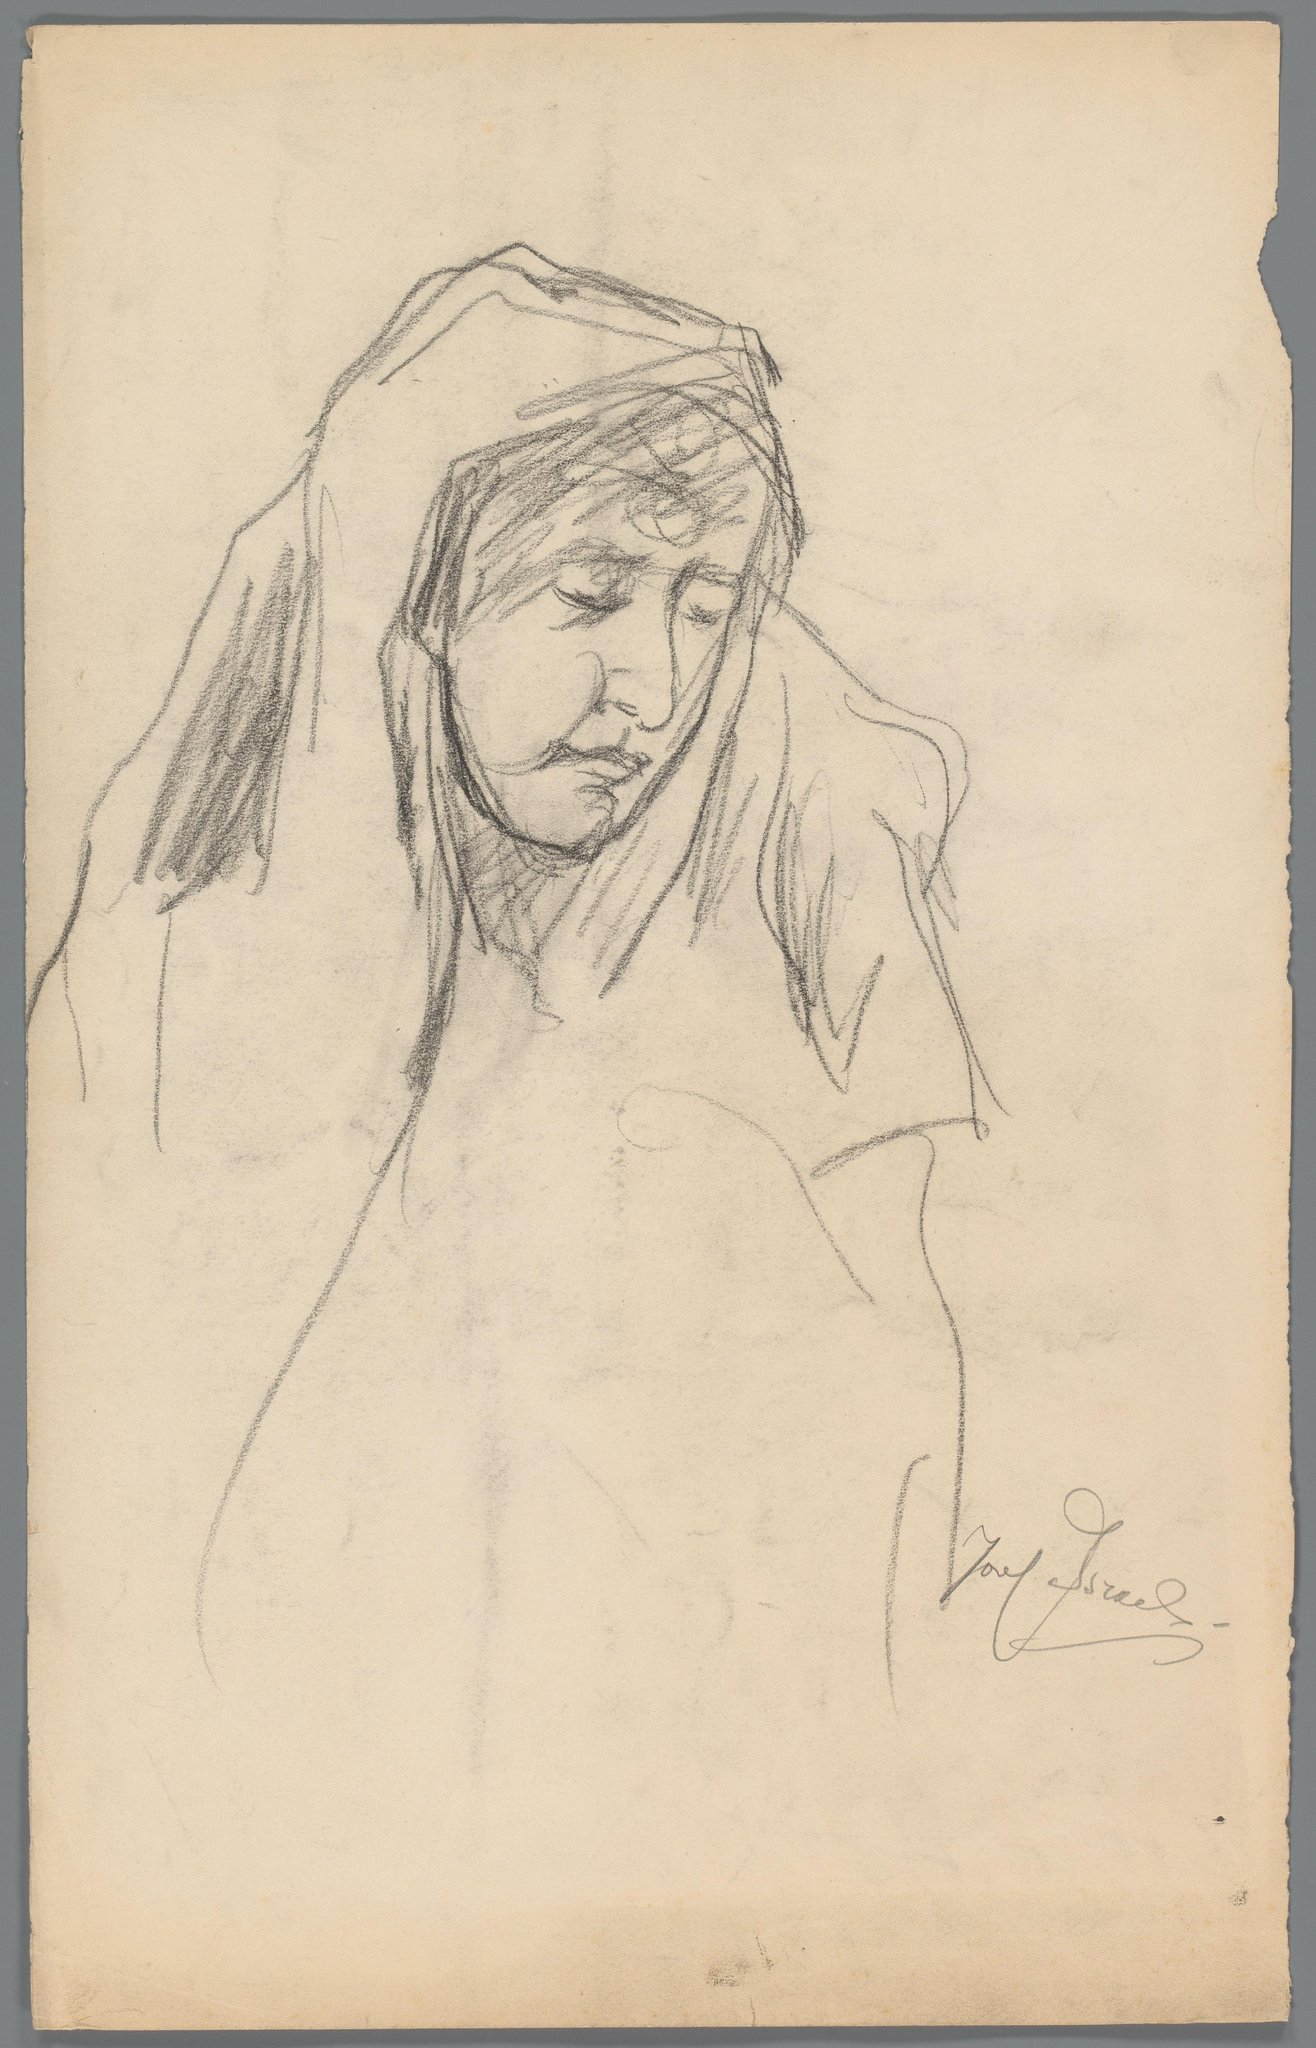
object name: drawing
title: Hoofd van een vrouw met hoofddoek, mogelijk Michal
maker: jozef israëls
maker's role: draughtsman, painter, print maker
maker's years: 1824-1911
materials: chalk, paper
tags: head-gear (with name), michal (not in biblical context)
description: Voorstudie voor het schilderij 'David en Saul' dat zich in het Groninger Museum bevindt.